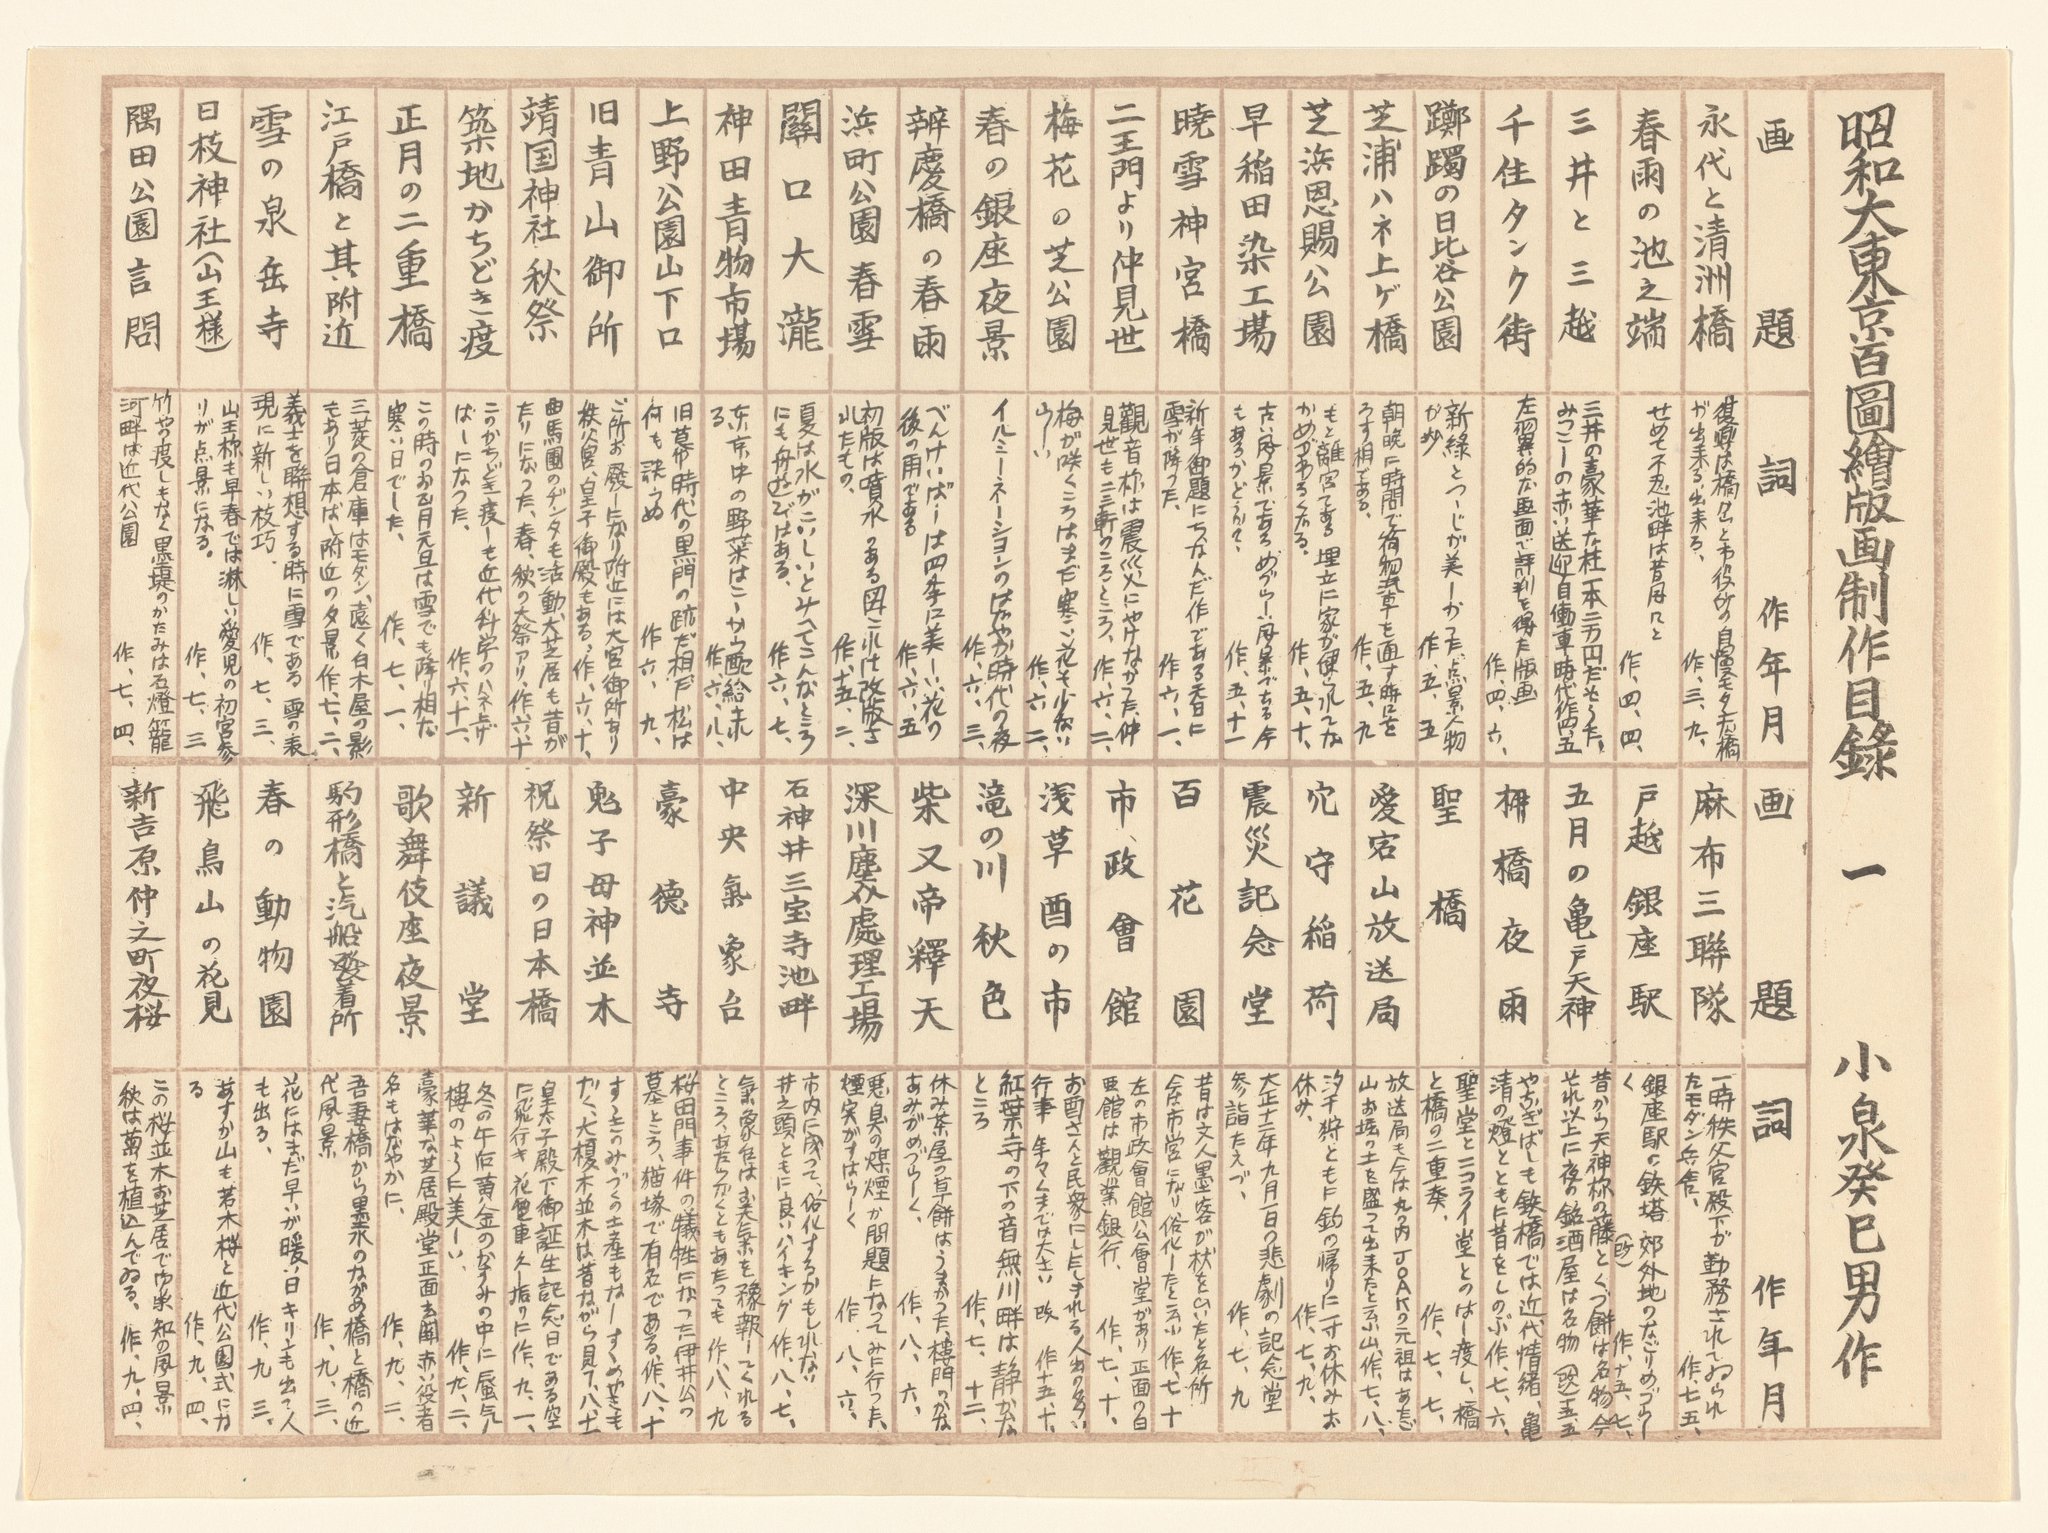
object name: print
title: Shōwa dai Tōkyō hyakuzue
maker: koizumi kishio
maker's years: 1893-1945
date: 1937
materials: paper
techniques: woodcut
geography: japan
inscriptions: signature: ‘Koizumi Kishio’, seal: ‘Izumi’, signature: ‘Koizumi Kisio’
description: Deel 1 van de inhoudsopgave voor de prentenserie 'Honderd gezichten op het grote Tokyo in de Shōwa-periode'. In september 1928 begon Koizumi Kishio aan zijn ambitieuze plan om honderd landschapsprenten met scènes in Tokyo volledig zelf te ontwerpen, hiervan zelf de drukblokken te snijden en zelf de prenten te drukken. De aanleiding voor het project was grote verandering die Tokyo onderging door de verwoestende Grote Kantō-aardbeving van 1923 en de wederopbouw die daarop volgde. Kishio maakt een bewuste verwijzing naar de bekende serie ‘Honderd beroemde gezichten op Edo’ door Utagawa Hiroshige (1797–1858), met prenten van locaties in Edo—de oude benaming voor Tokyo. Kishio toont overwegend moderne gebouwen, instituten en mensen die de tijdsgeest van de jaren 1920 en 1930 weerspiegelen. Sommige prenten onthullen daarentegen een nostalgische blik op overblijfselen uit het oude Edo. Kishio verkocht de prenten aan de hand van een abonnement met een limiet van vijftig leden, die elke maand een of twee prenten zouden ontvangen. Het project begon met negen abonnementen, maar al na de tweede maand werden meerdere daarvan opgezegd en slechts vier mecenassen bleven lid tot en met de voltooiing van de serie. Hij bracht het honderdste ontwerp uit in 1937. Zijn leermeester Ishii Hakutei schreef een inleiding in 1938 die Kishio verwerkte tot een prent en toevoegde aan de set. Tussen 1939 en 1940 maakte hij nog eens negen extra ontwerpen. Met acht van deze ontwerpen verving hij oudere nummers uit de serie, mogelijk omdat hij niet tevreden was met de composities. Uiteindelijk lukte het Kishio om tien complete sets te verkopen aan de shin hanga-uitgever Watanabe Shōzaburō en liet hiervoor speciale houten dozen maken. Deze prent behoort tot een van die tien sets.